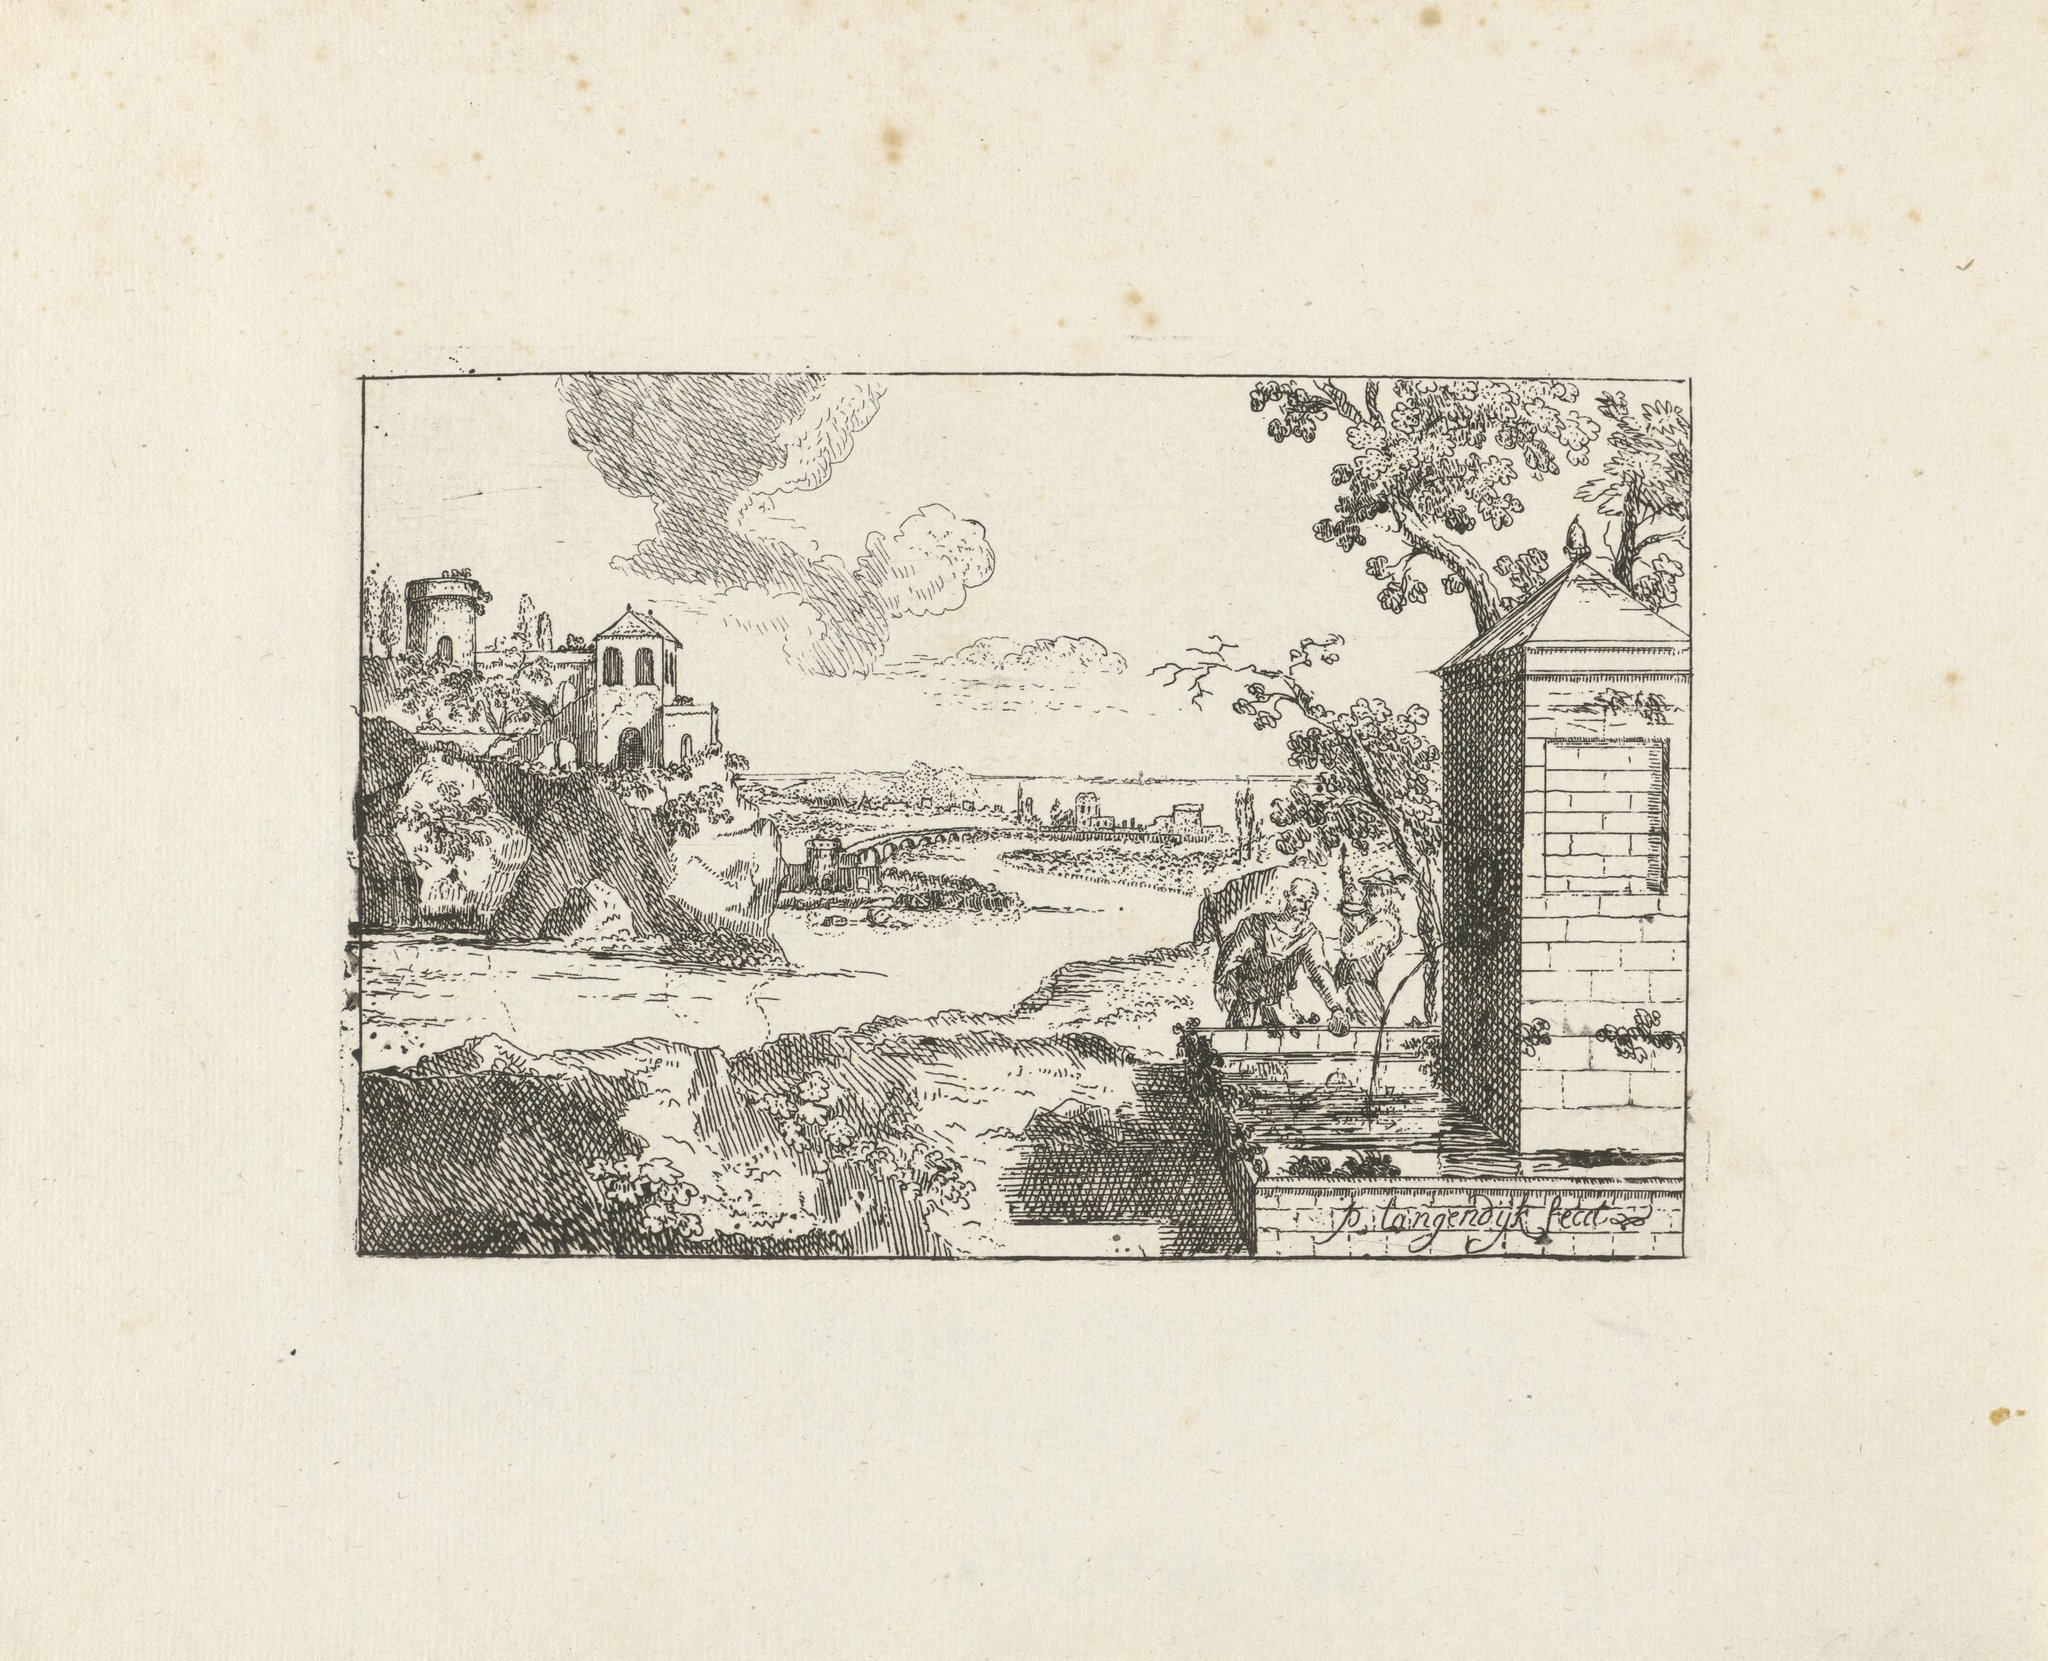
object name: print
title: Riviergezicht met figuren bij een bron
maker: pieter langendijk (i)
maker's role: print maker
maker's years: 1683-1756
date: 1693-1756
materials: paper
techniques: etching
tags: river bank - hh - ideal landscapes, utilitarian, public pump or water fountain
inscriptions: collector's mark: Lugt 240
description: Riviergezicht met rechts op de voorgrond figuren bij een bron.